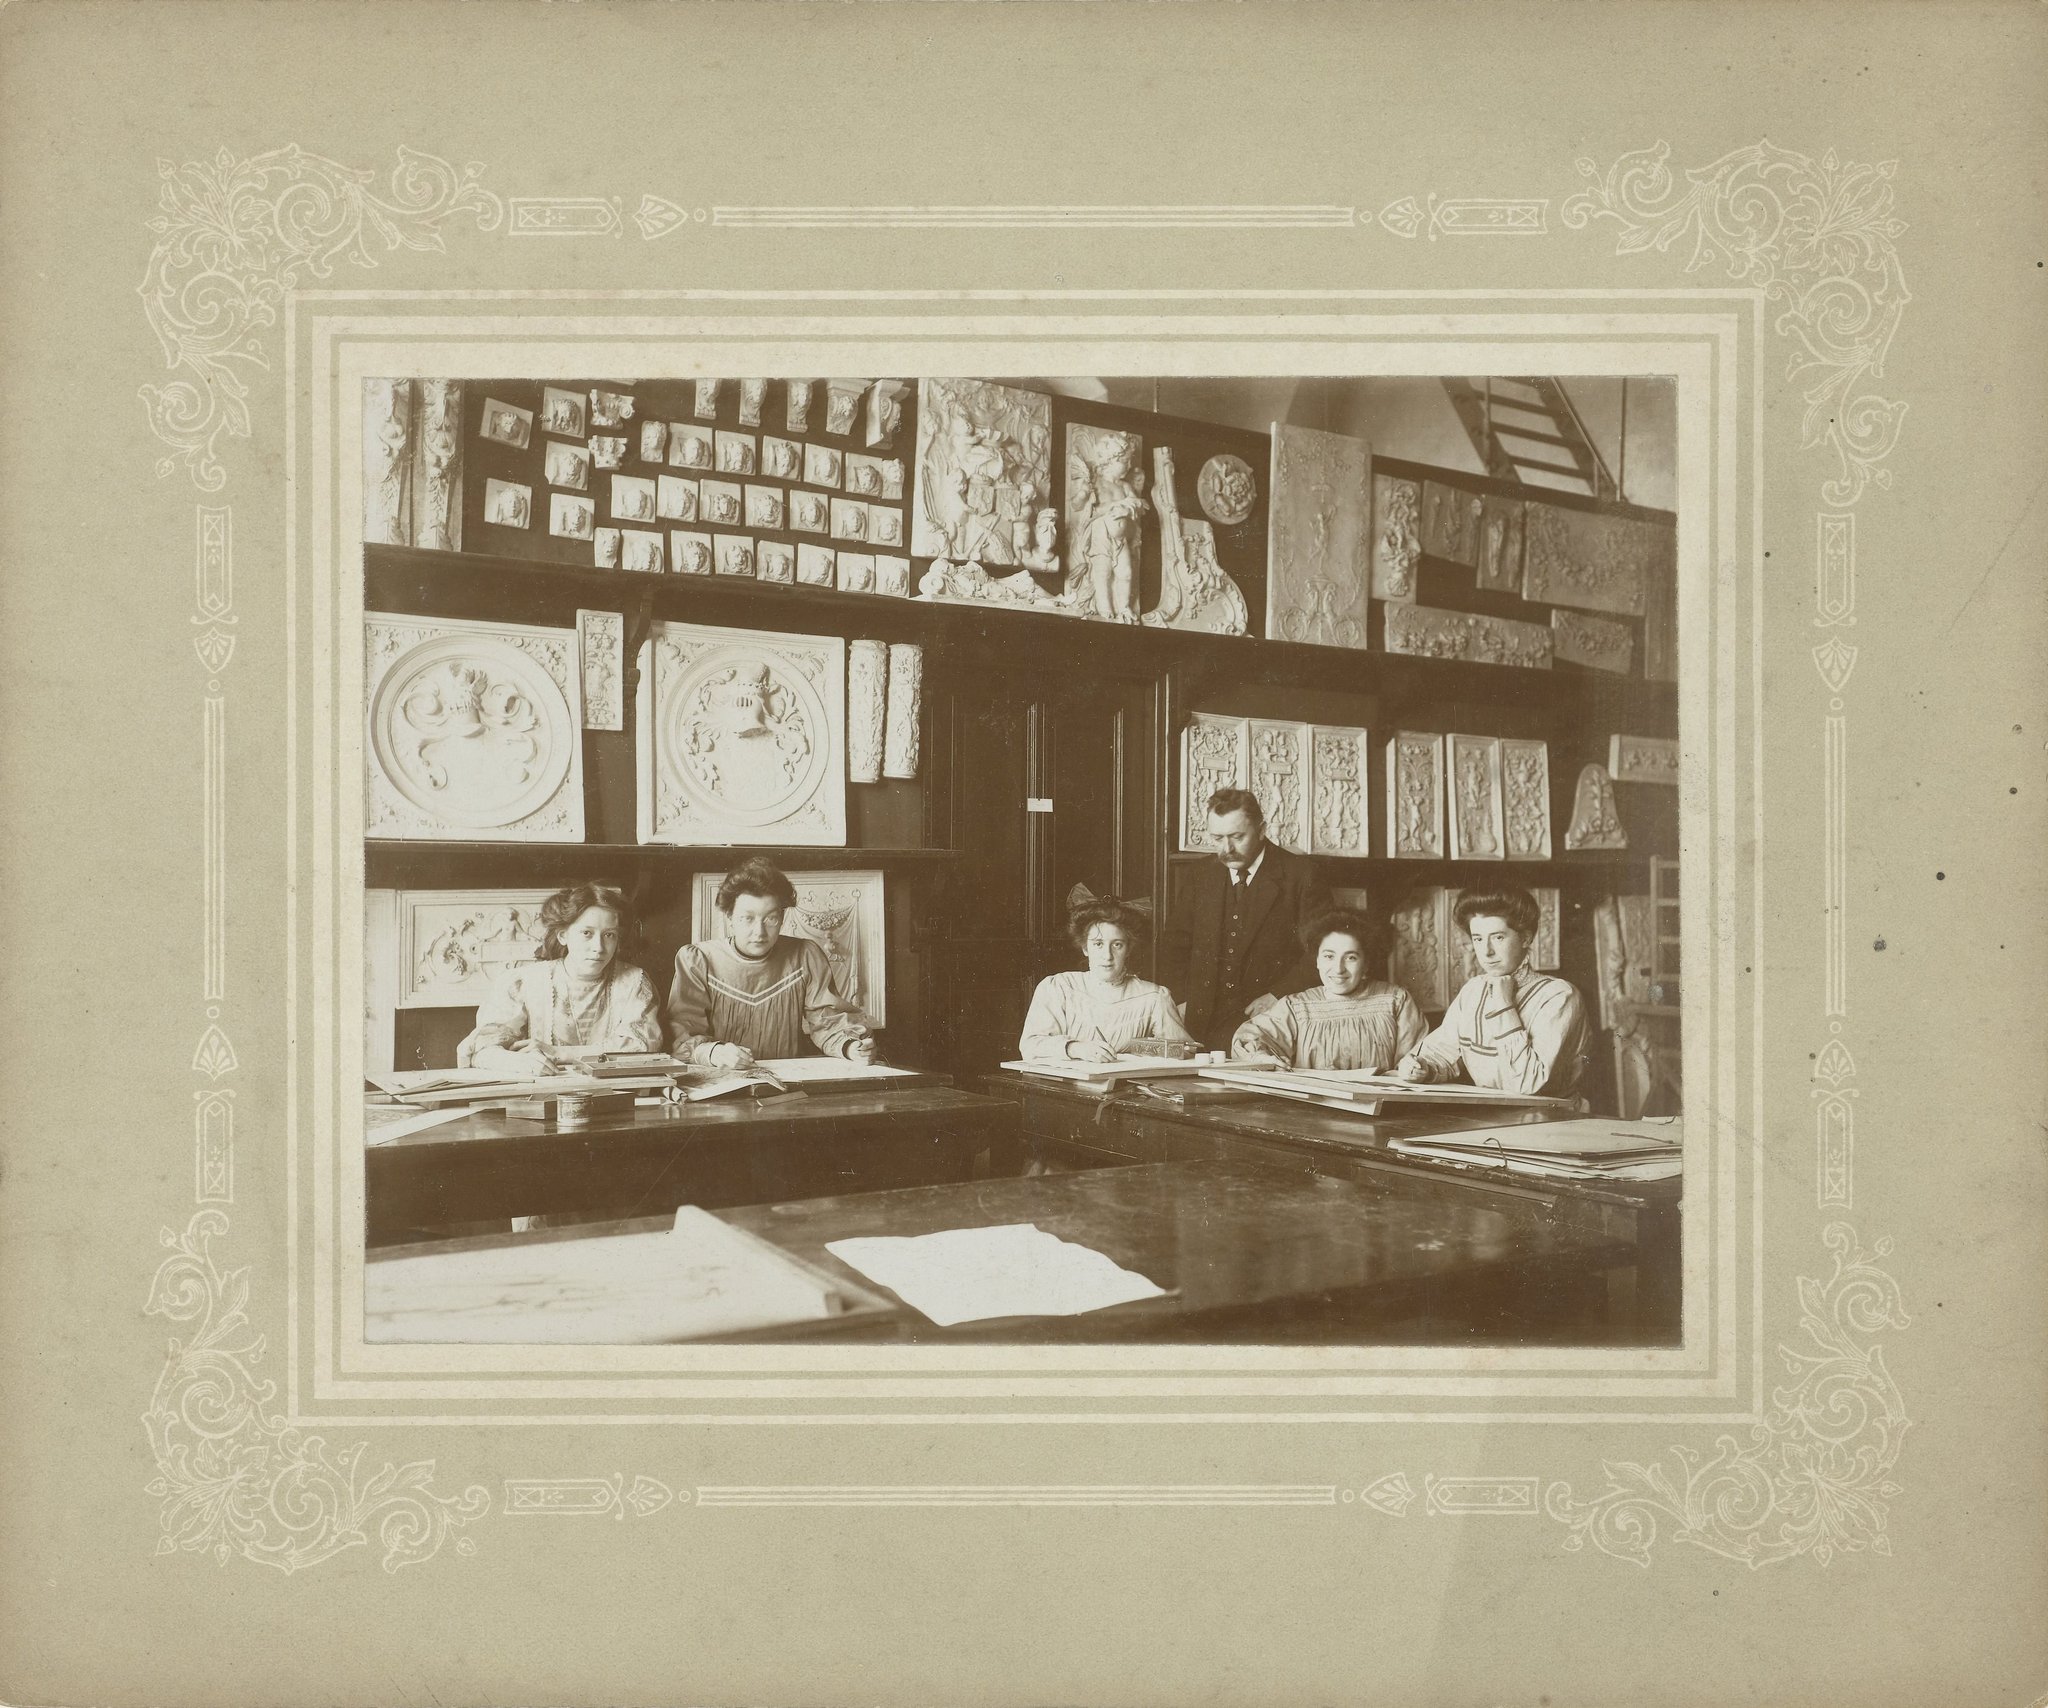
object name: photograph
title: Werkplaats Rijksmuseum, vermoedelijk opleidingsplaats voor leerlingen kunst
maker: Anonymous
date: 1900-1920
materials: cardboard, photographic support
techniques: albumen print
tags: workshop